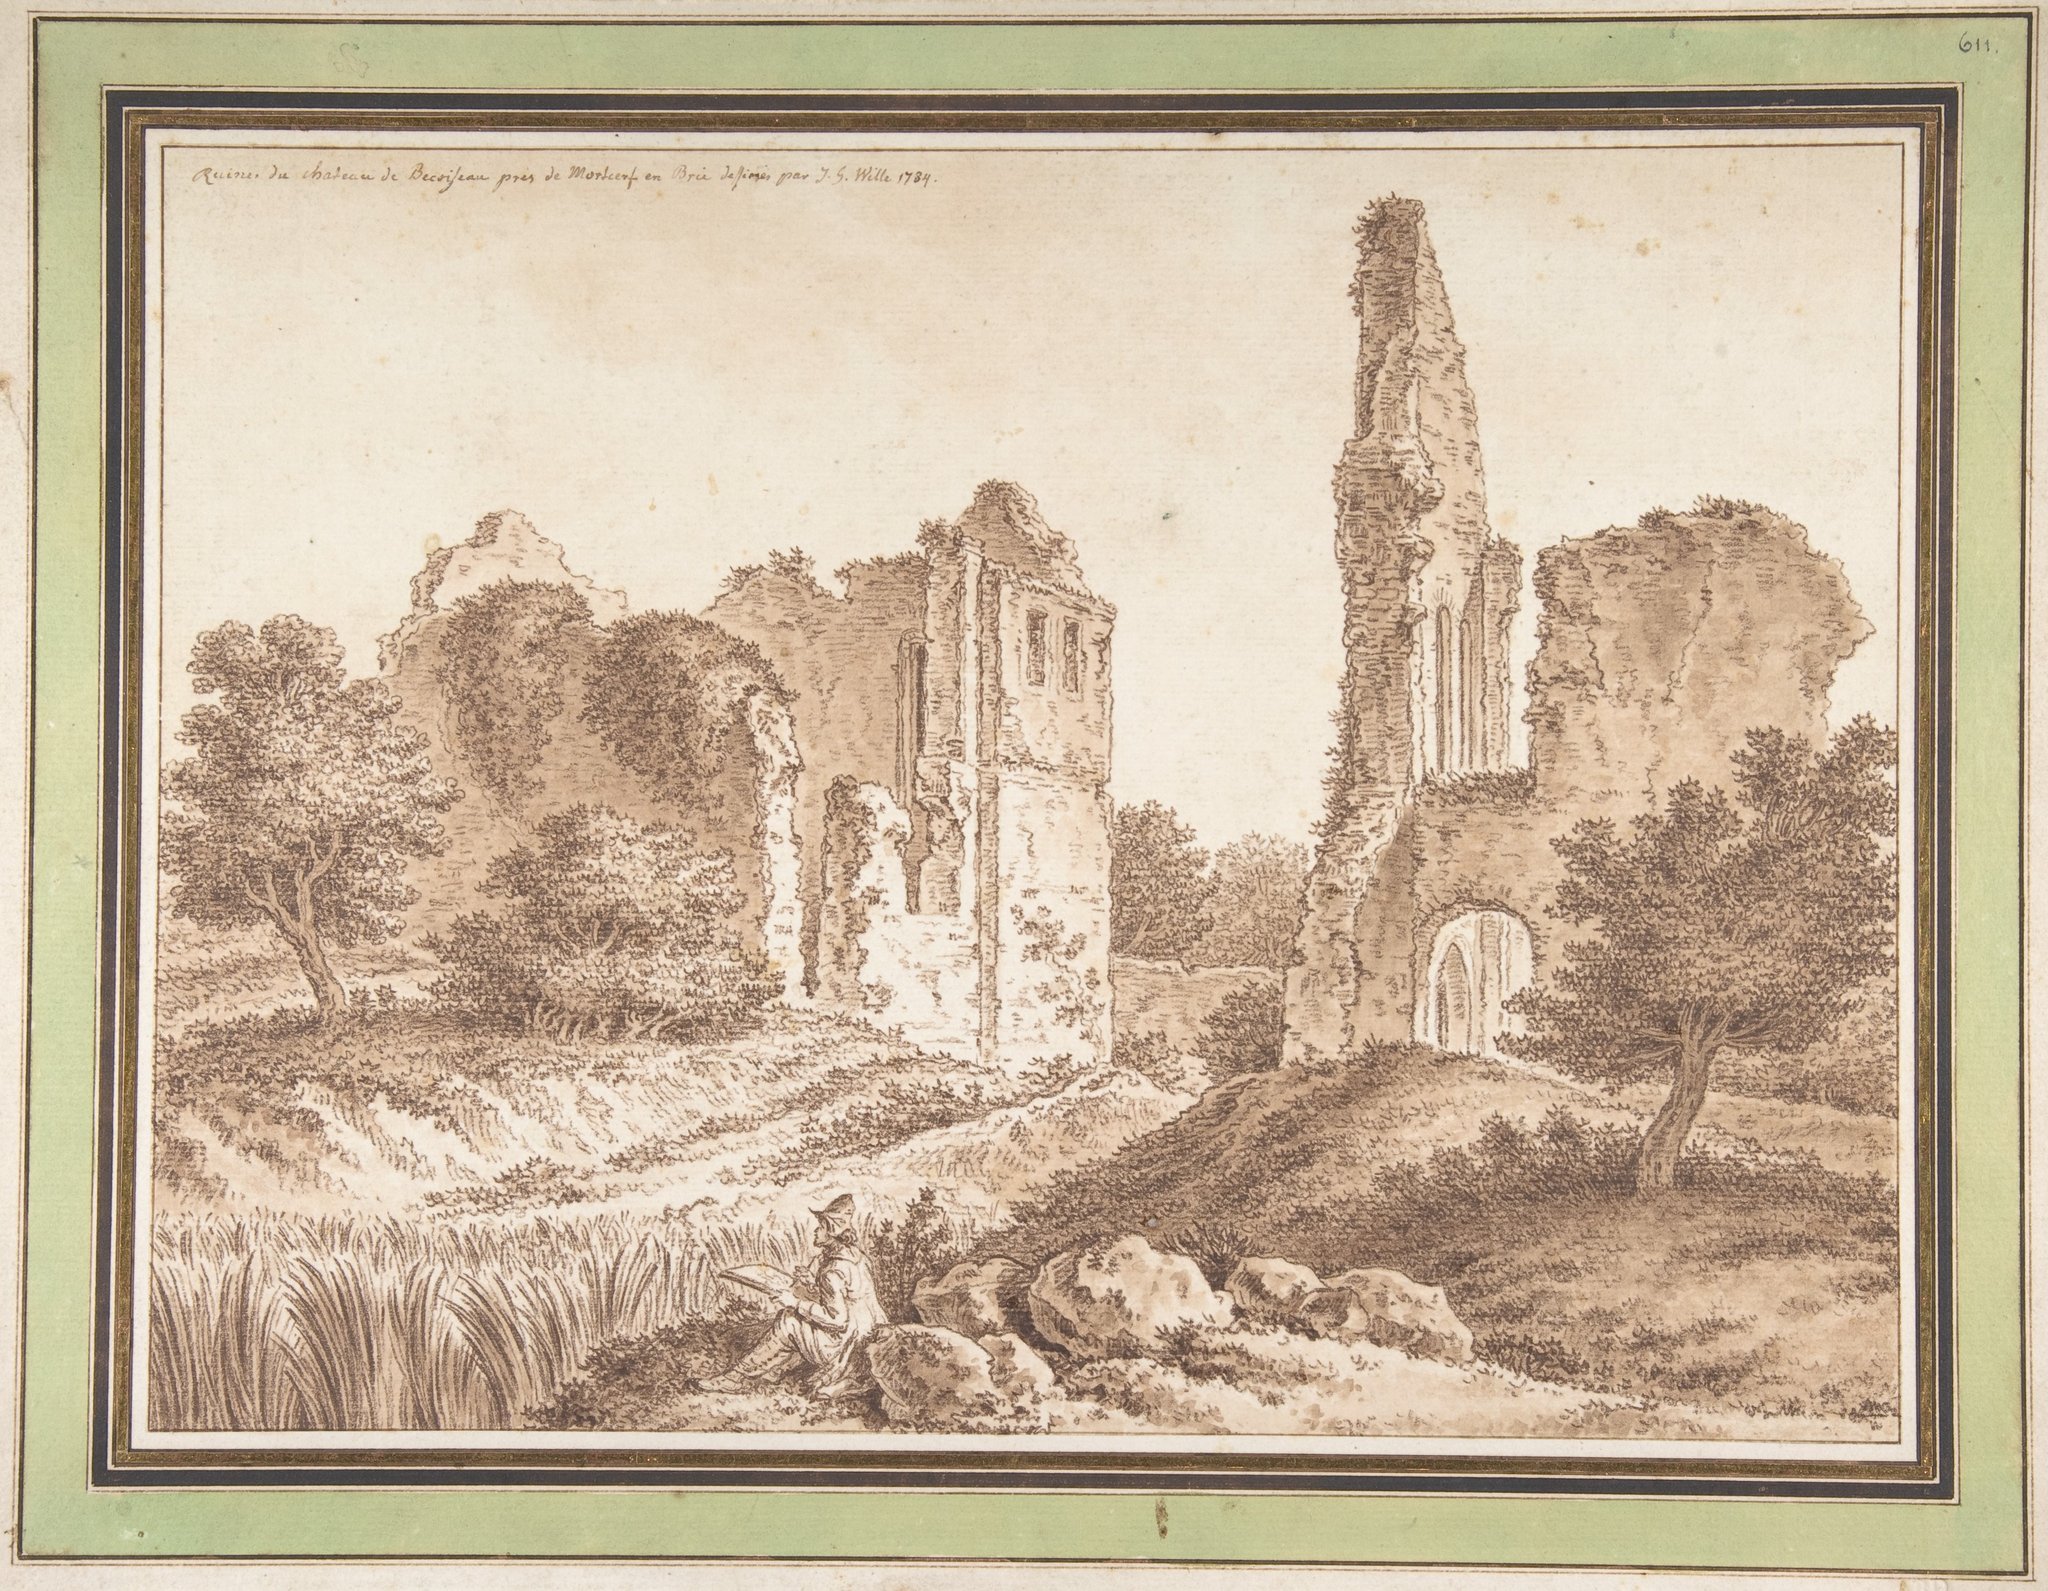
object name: drawing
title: Ruins of the Château of Becoiseau, near Mortcerf (seine-et-Marne)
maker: johann georg wille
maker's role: artist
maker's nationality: german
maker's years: 1715-1808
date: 1784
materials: chalk, ink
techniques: brush, pen, wash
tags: human figures,ruins,trees